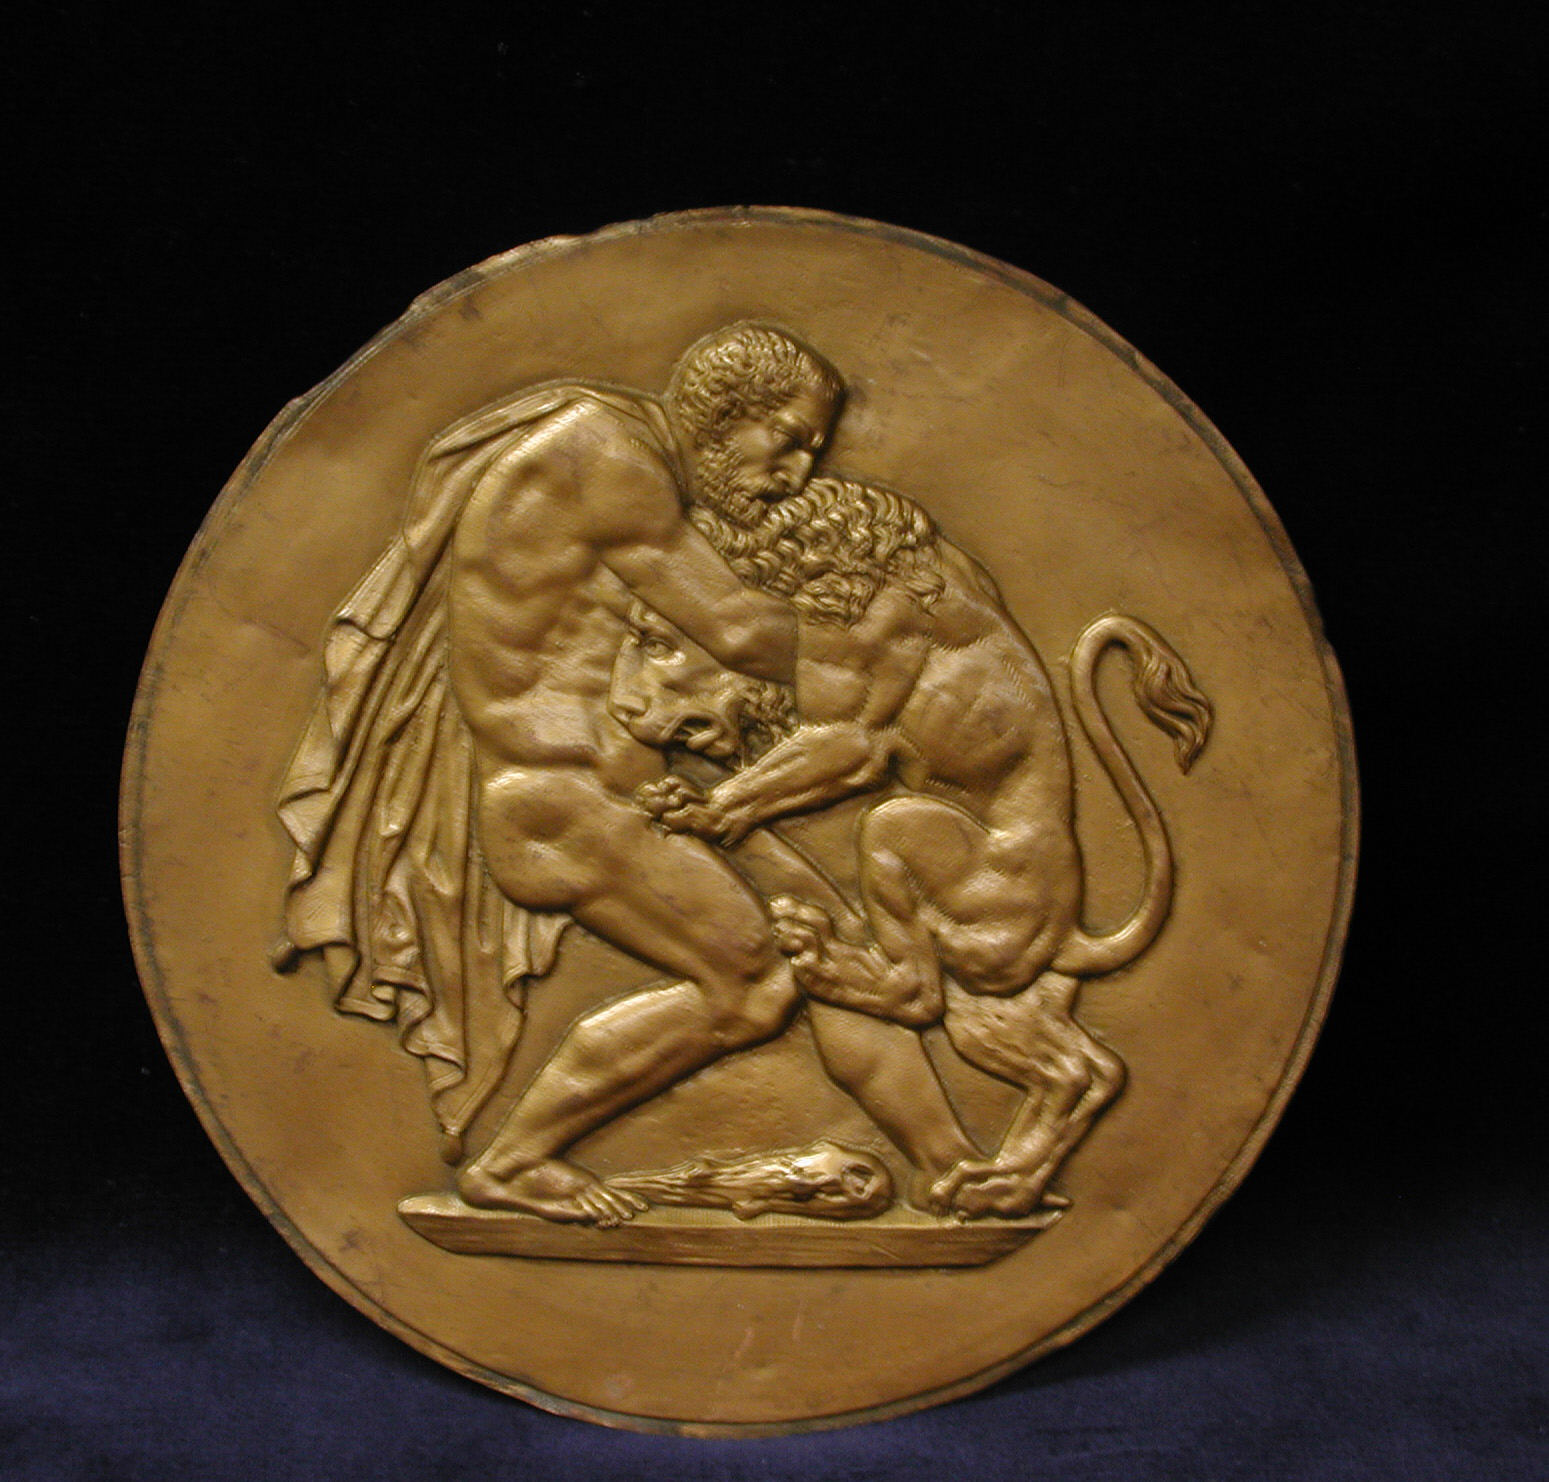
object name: medallion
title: Hercules and Lion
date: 1801-1900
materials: copper, lead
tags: hercules,lions